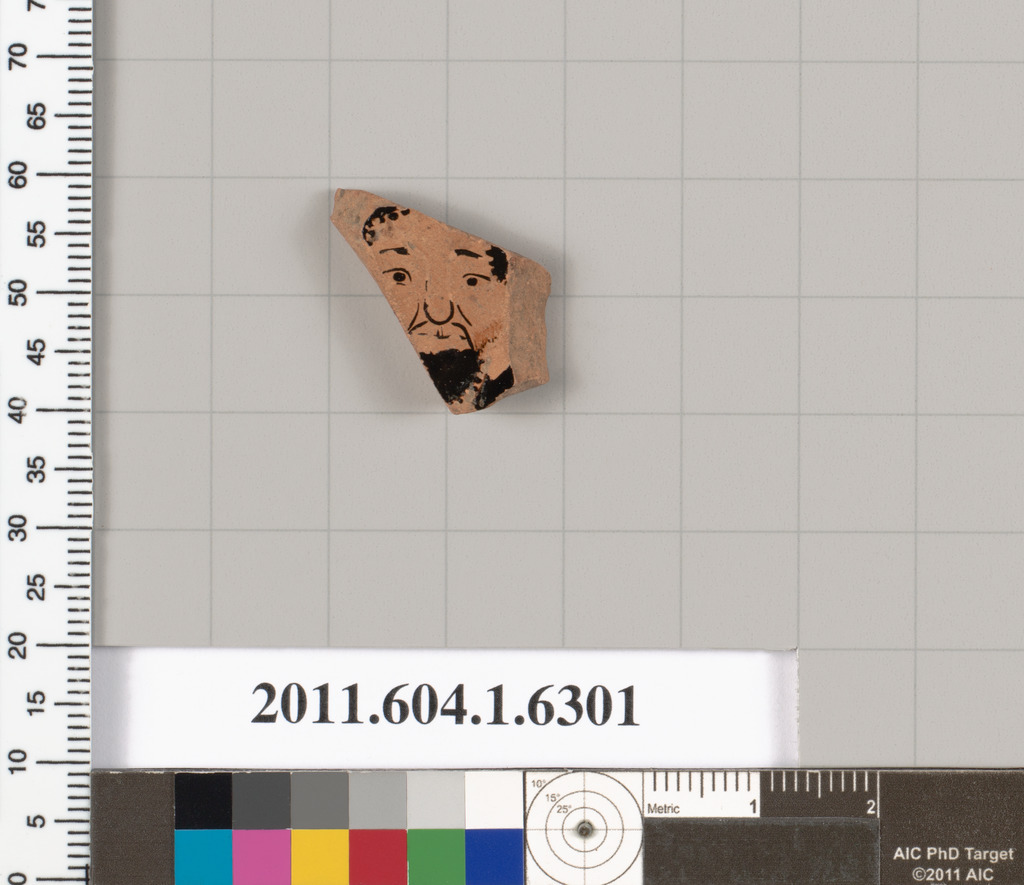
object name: kylix fragment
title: Terracotta fragment of a kylix (drinking cup)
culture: greek, attic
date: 500-480 BCE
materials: terracotta